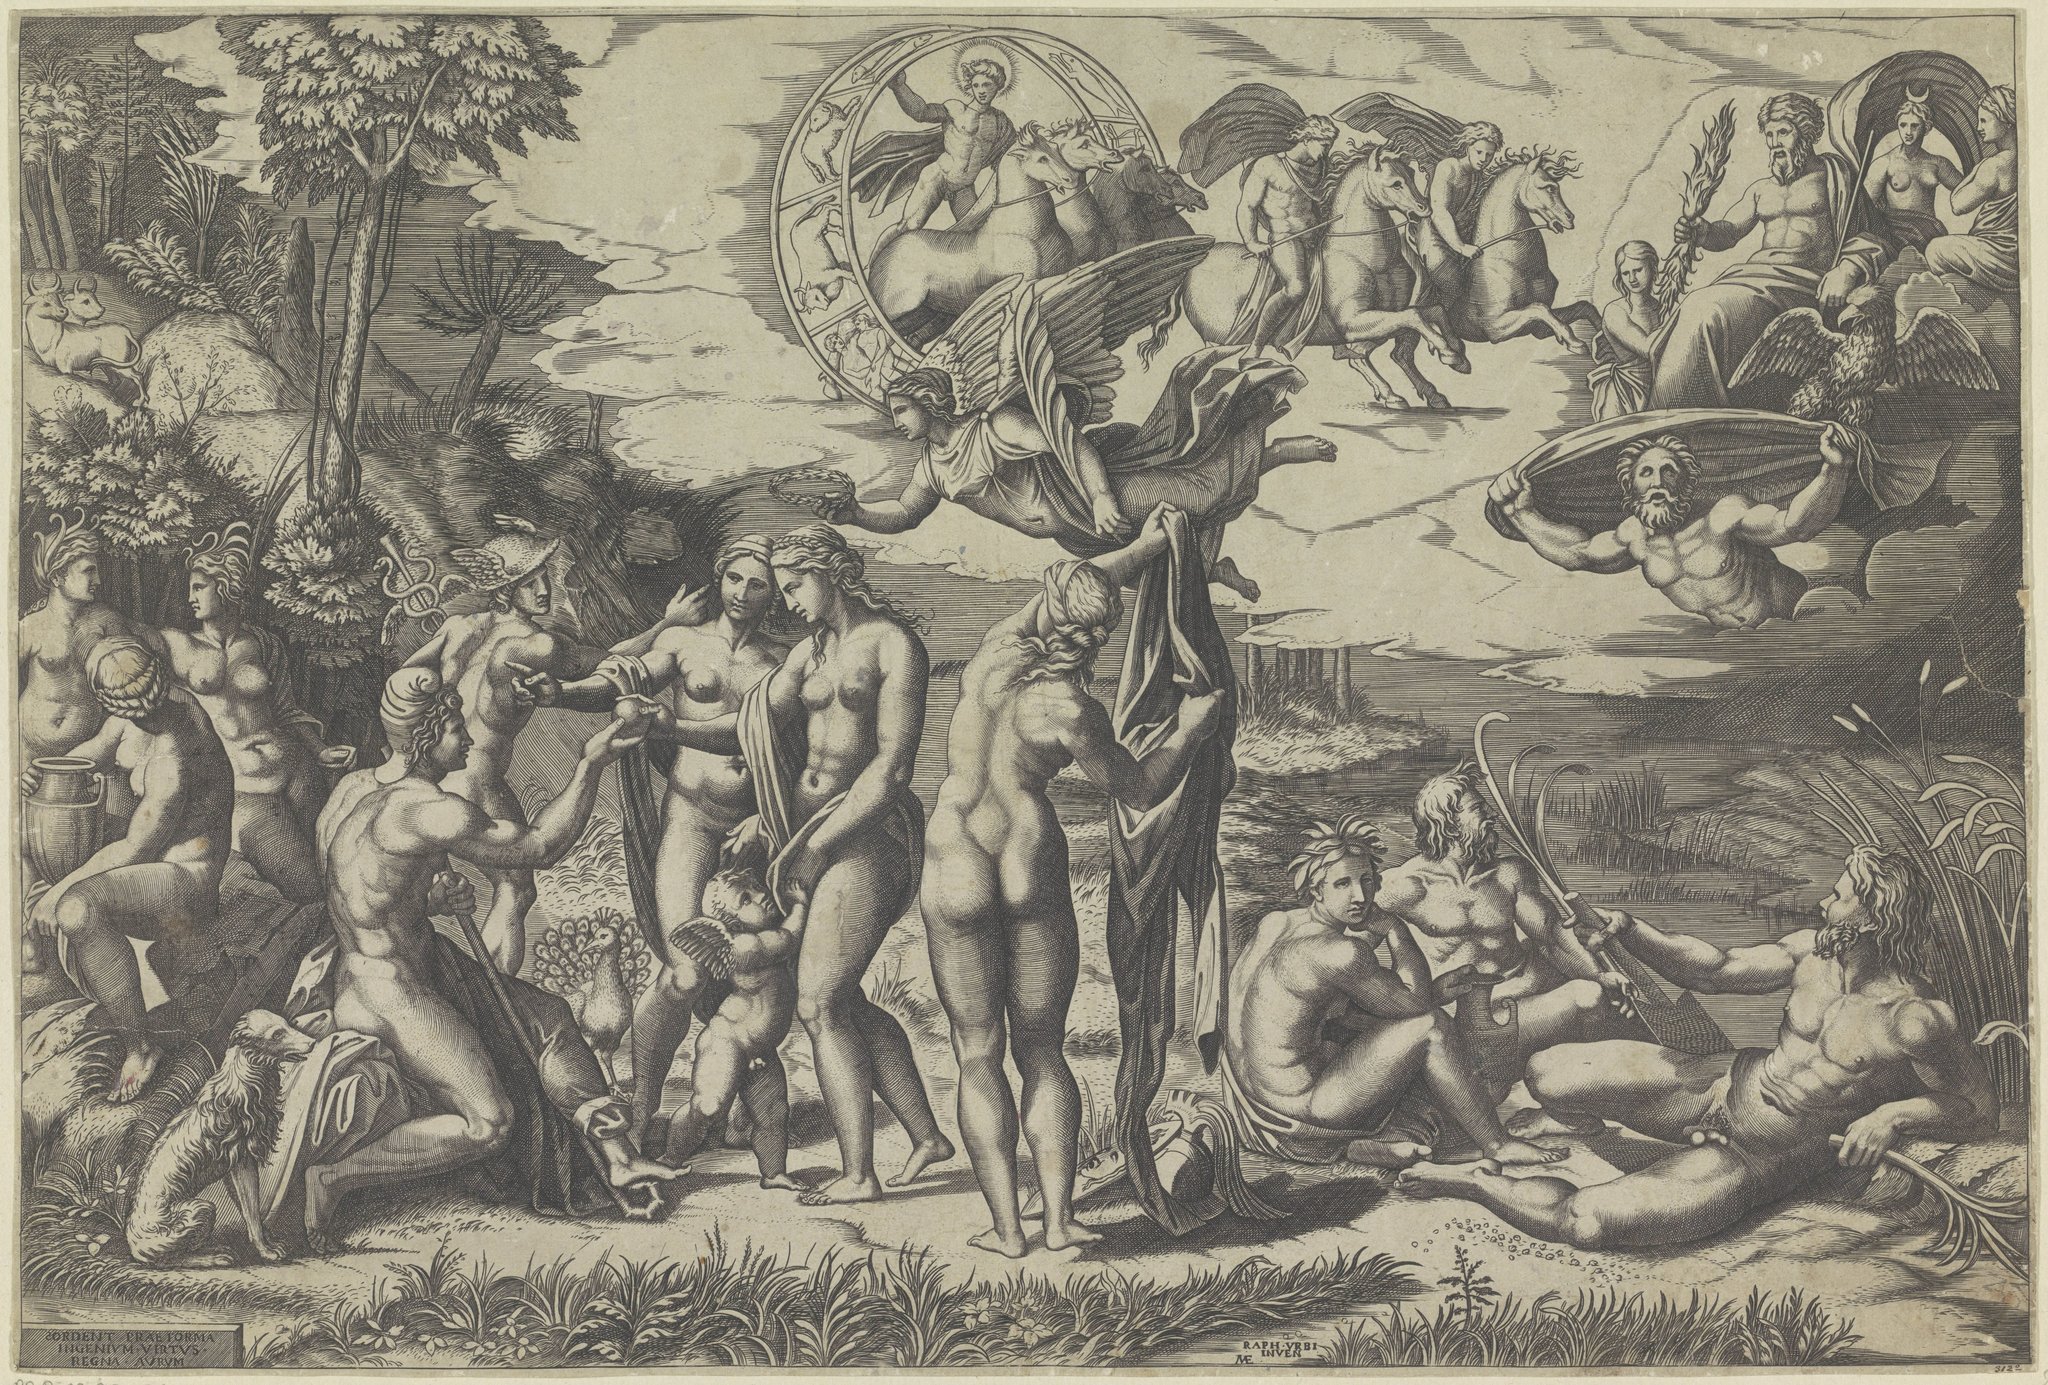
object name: print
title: Het oordeel van Paris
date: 1498-1532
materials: paper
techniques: engraving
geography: italy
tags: the judgement of paris (without mercury)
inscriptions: collector's mark: Lugt 240, inscription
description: Een bijeenkomst van goden in een landschap. Op de voorgrond maakt Paris een keuze tussen Venus, Juno en Minerva. Achter Paris staat Mercurius. Apollo vliegt op zijn zonnewagen door de lucht.